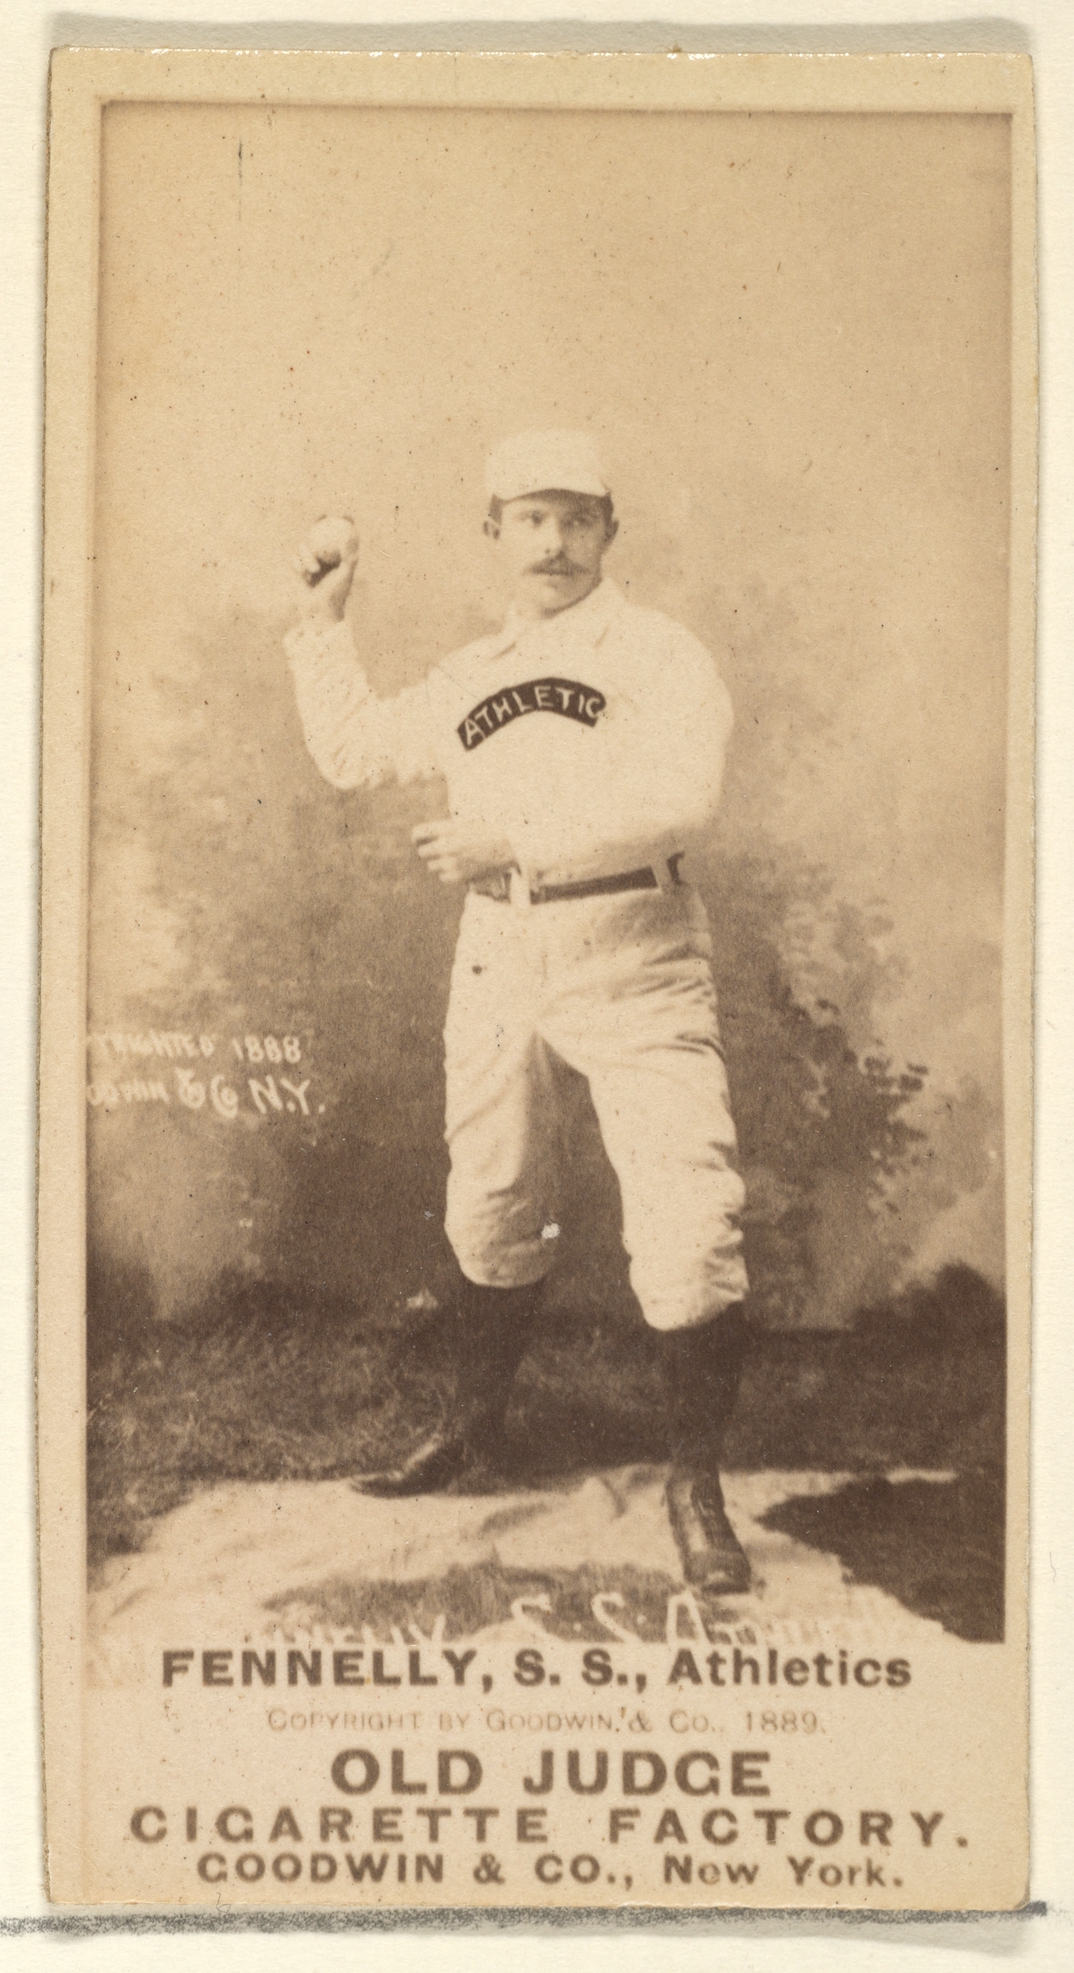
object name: baseball card, photograph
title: Fennelly, Shortstop, Philadelphia Athletics, from the Old Judge series (N172) for Old Judge Cigarettes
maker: goodwin & company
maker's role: publisher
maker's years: 1850-1950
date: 1889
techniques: albumen silver print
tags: men,portraits,baseball,athletes